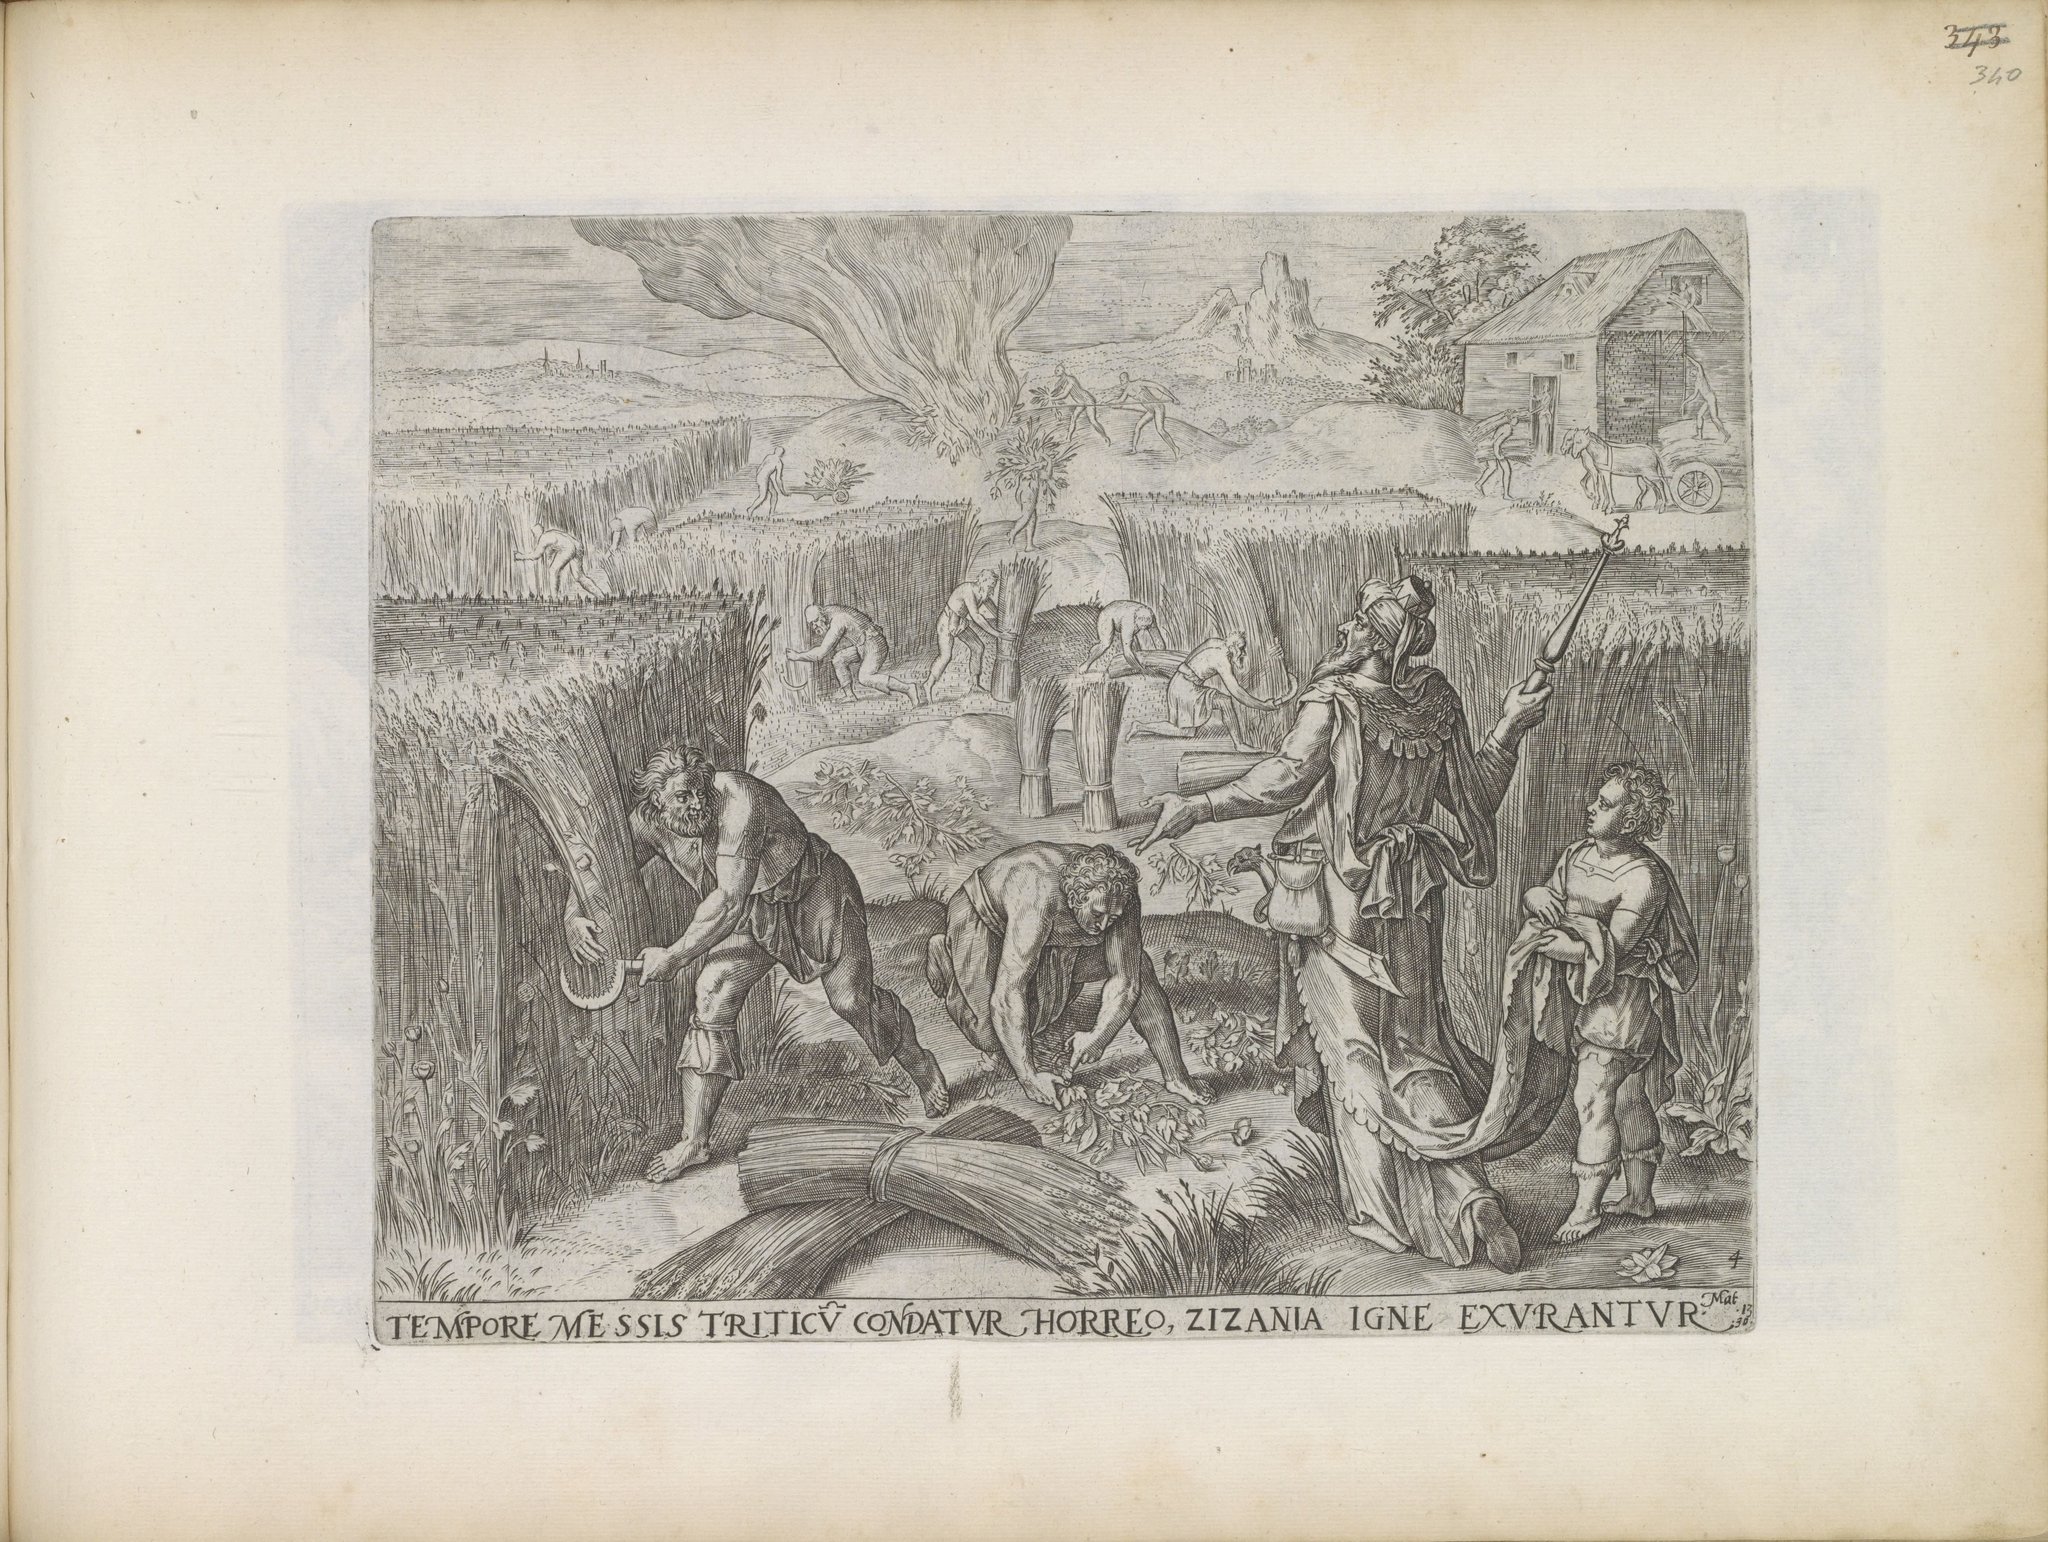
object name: print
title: Gelijkenis van de zaaier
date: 1568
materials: paper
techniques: engraving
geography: amsterdam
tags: in time of the harvest the tares are bound and burned, but the wheat is gathered and put in the barn of the lord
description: De landheer, met een scepter in de hand, geeft de opdracht om de oogst binnen te halen. Het graan wordt geoogst en het onkruid wordt verzameld en verbrand. Een jongen houdt het kleed van de landheer vast. Onder de voorstelling een verwijzing in het Latijn naar de Bijbeltekst in Mat. 13:30. Deze prent maakt deel uit van een album.